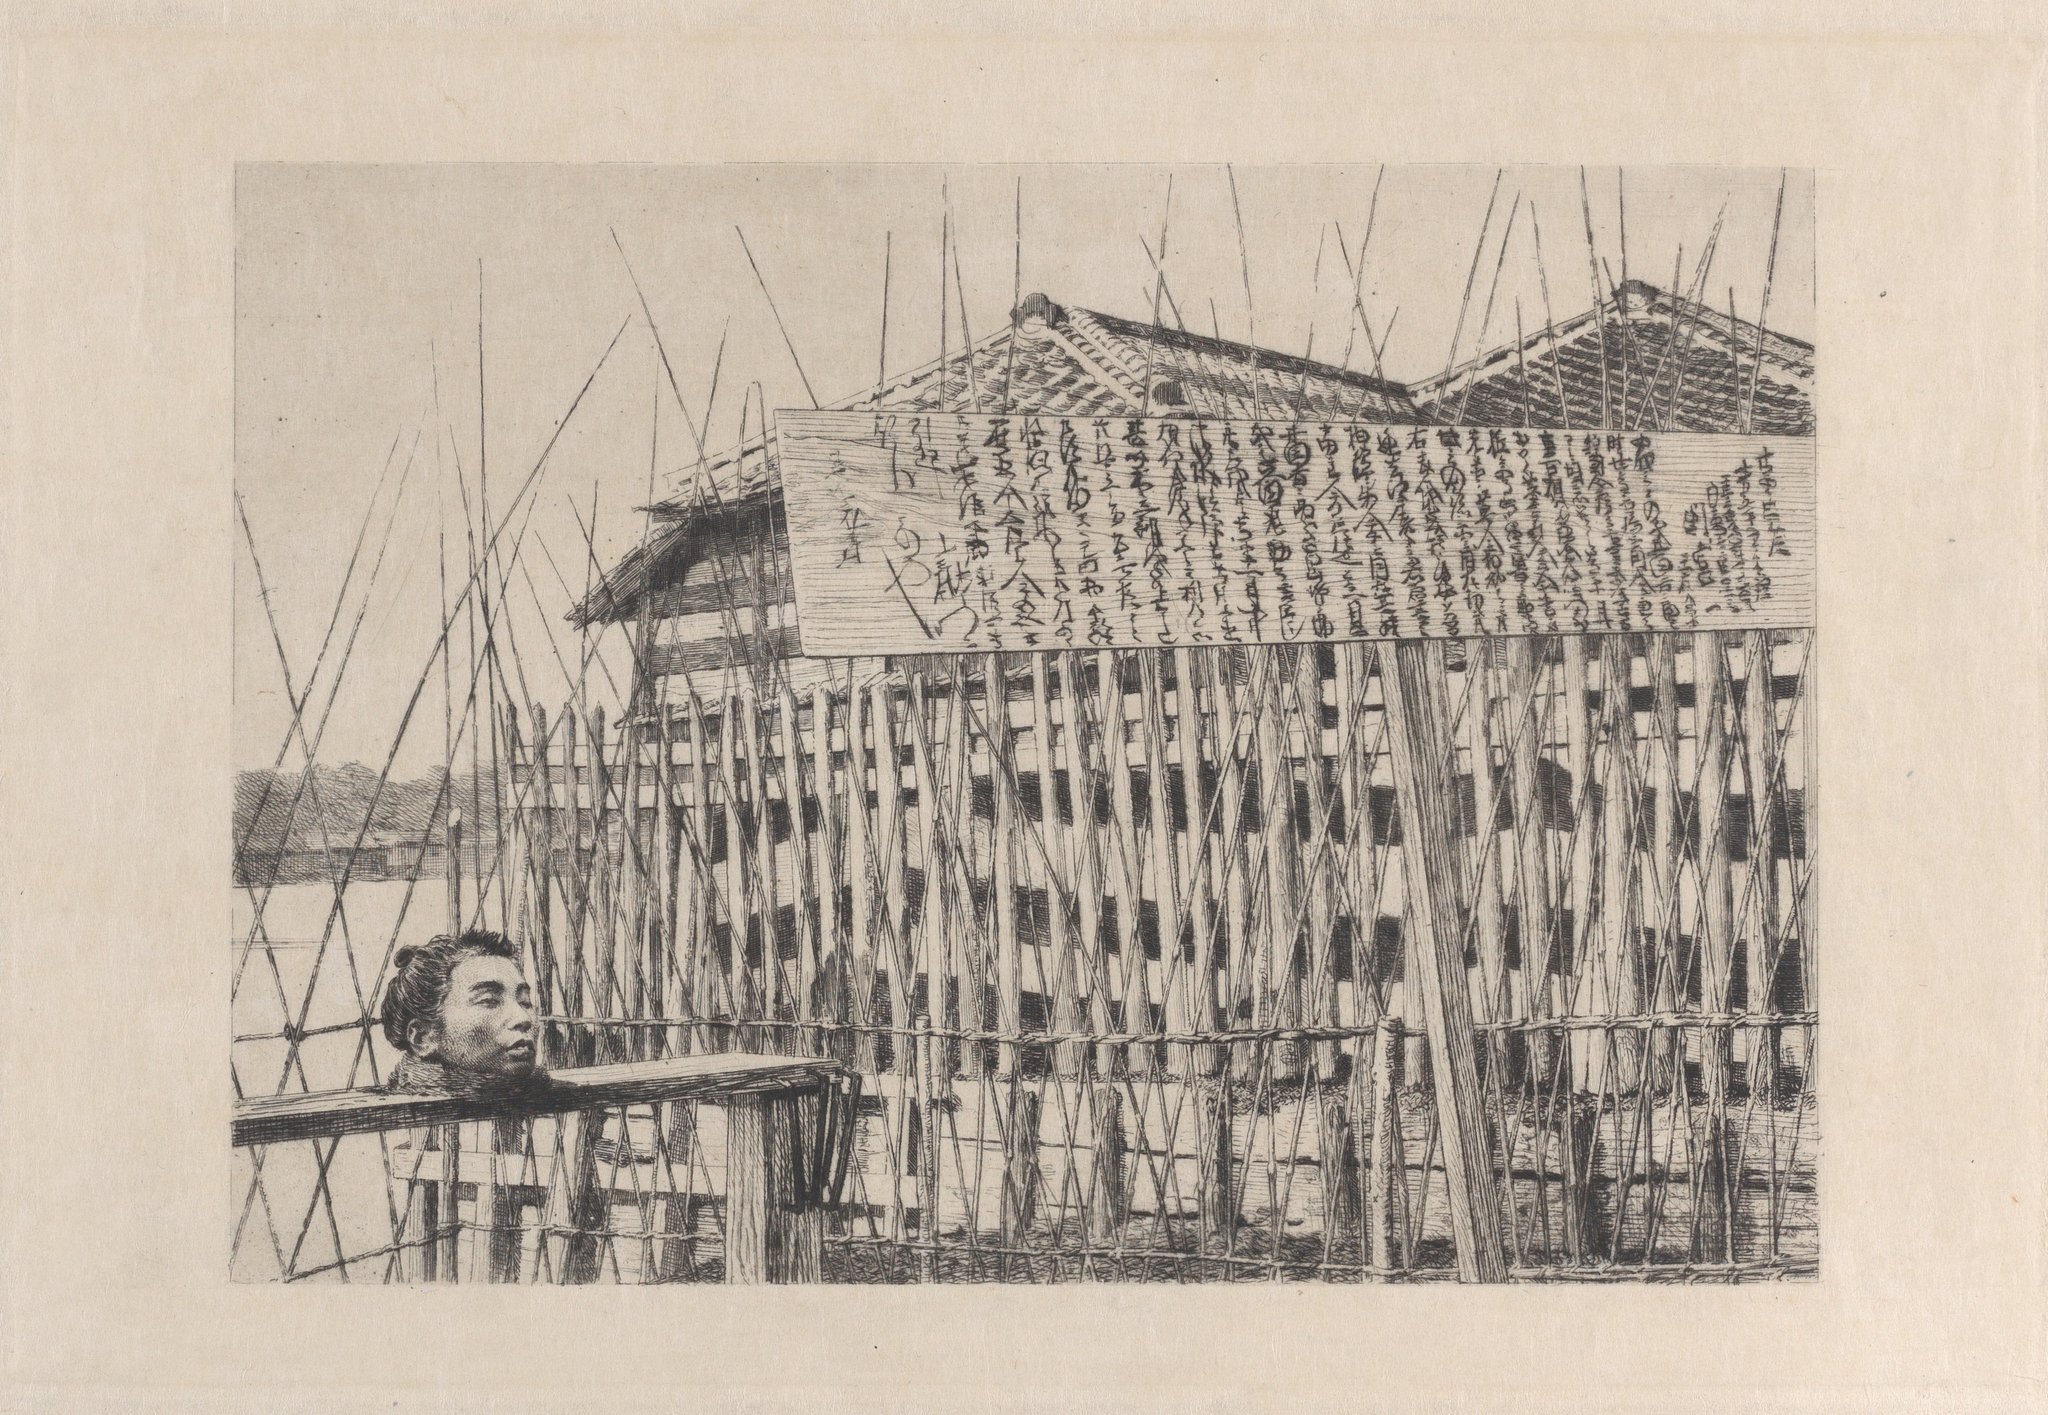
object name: print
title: Execution in Japan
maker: jules-ferdinand jacquemart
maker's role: artist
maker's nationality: french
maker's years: 1837-1880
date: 1865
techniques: etching